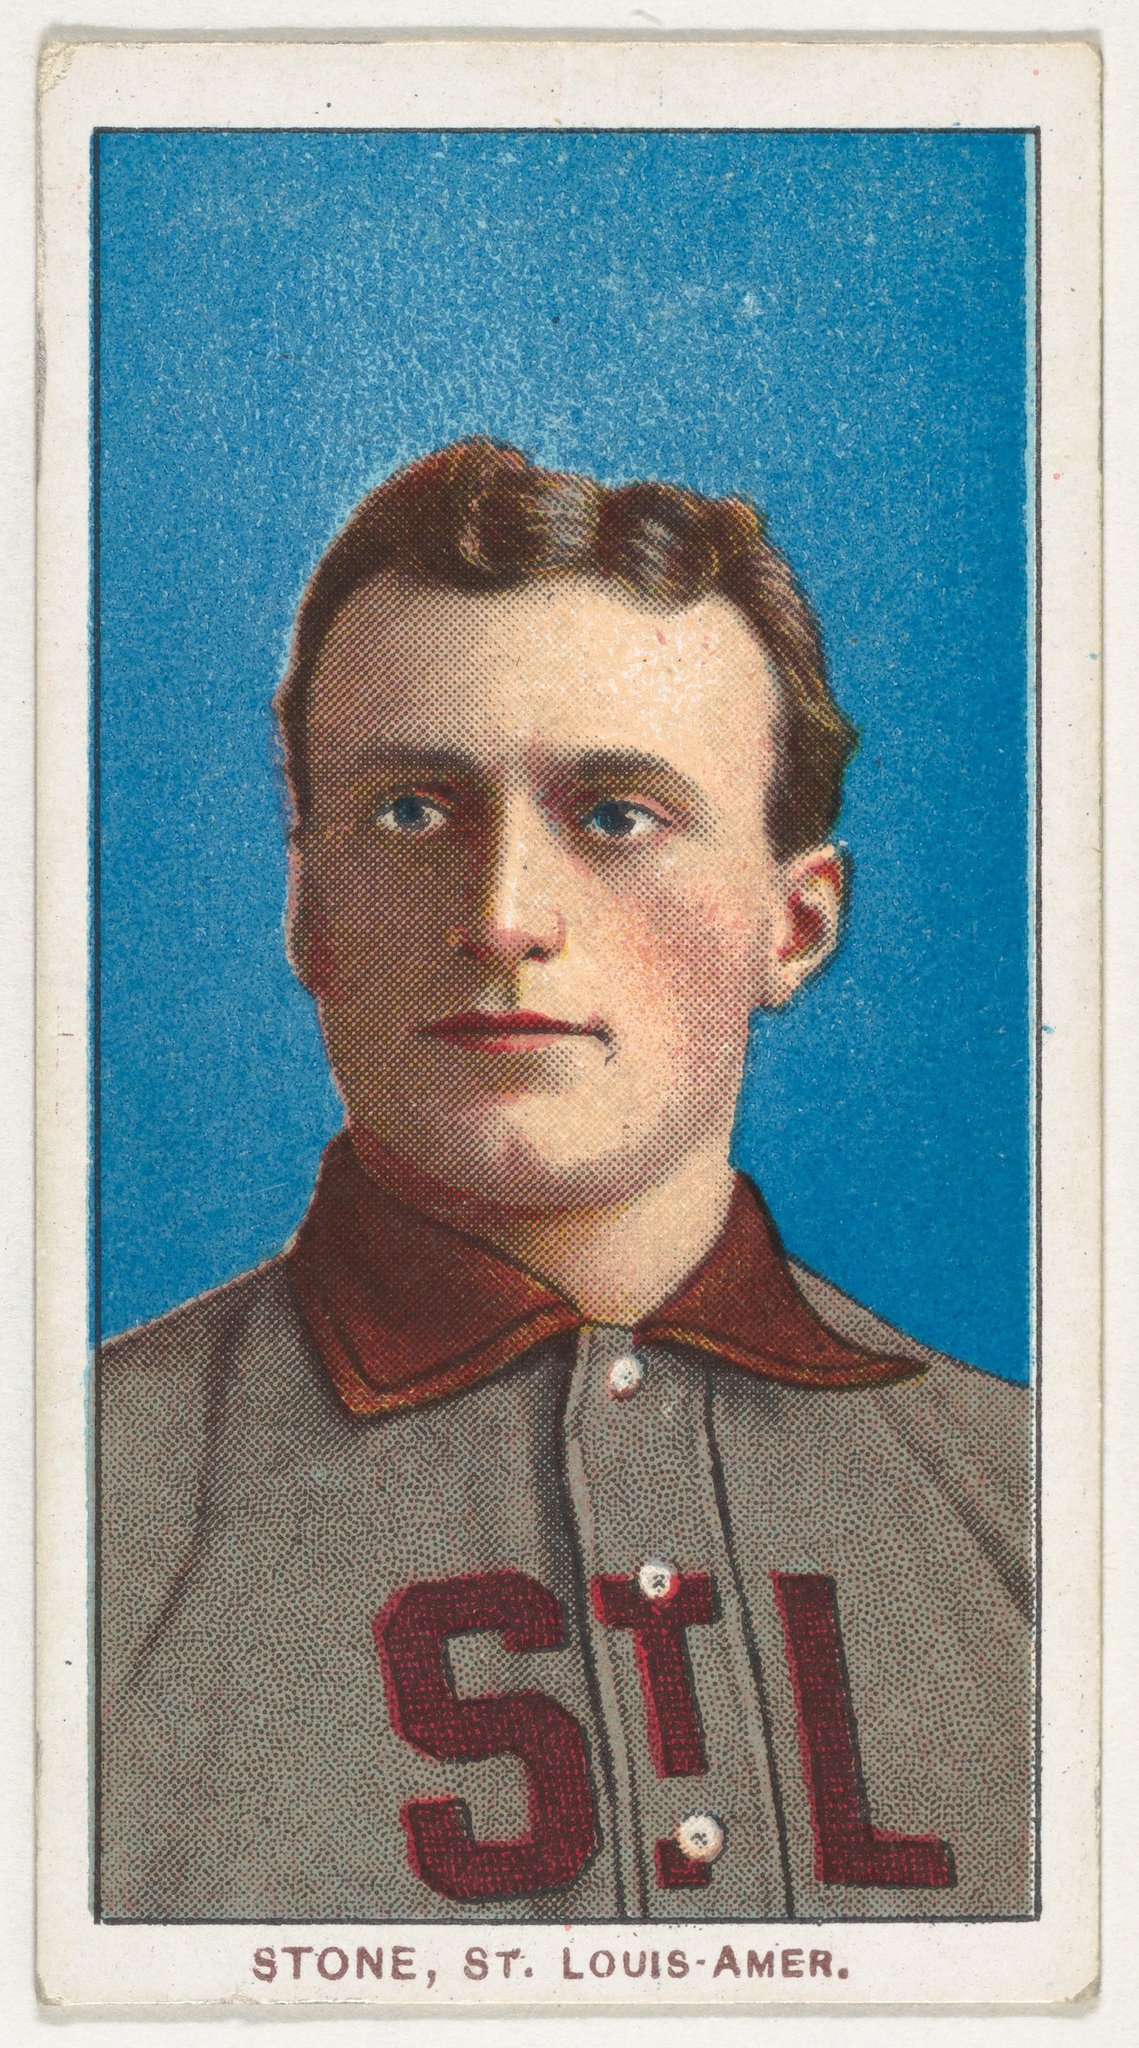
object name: baseball card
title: Stone, St. Louis, American League, from the White Border series (T206) for the American Tobacco Company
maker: american tobacco company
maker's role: publisher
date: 1909-1911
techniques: lithography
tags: men,portraits,baseball,athletes